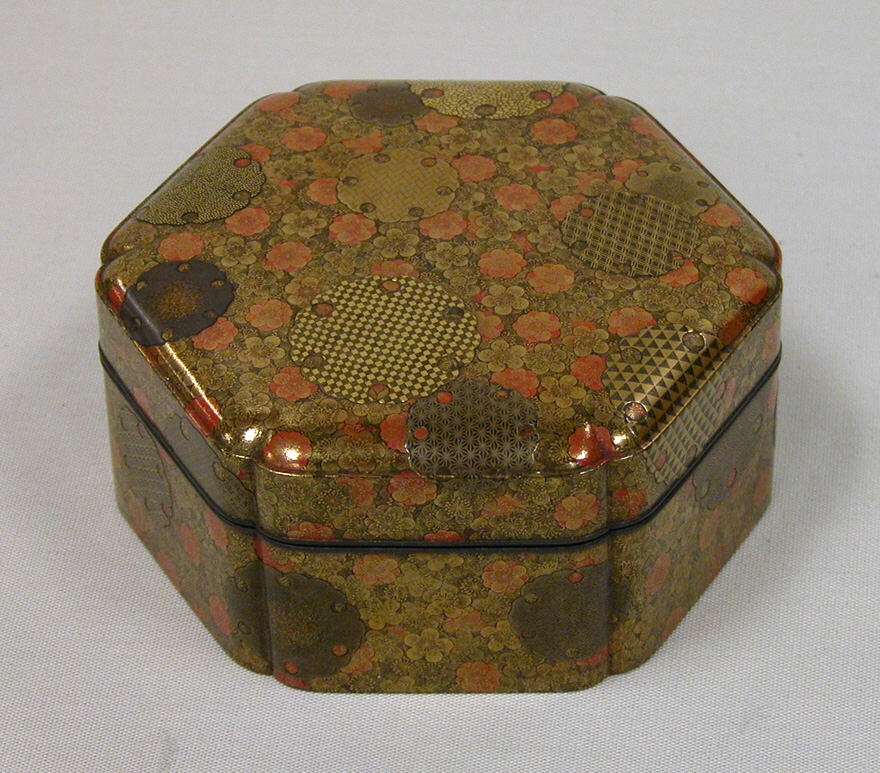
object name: incense box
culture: japanese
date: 1767-1833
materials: lacquer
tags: flowers